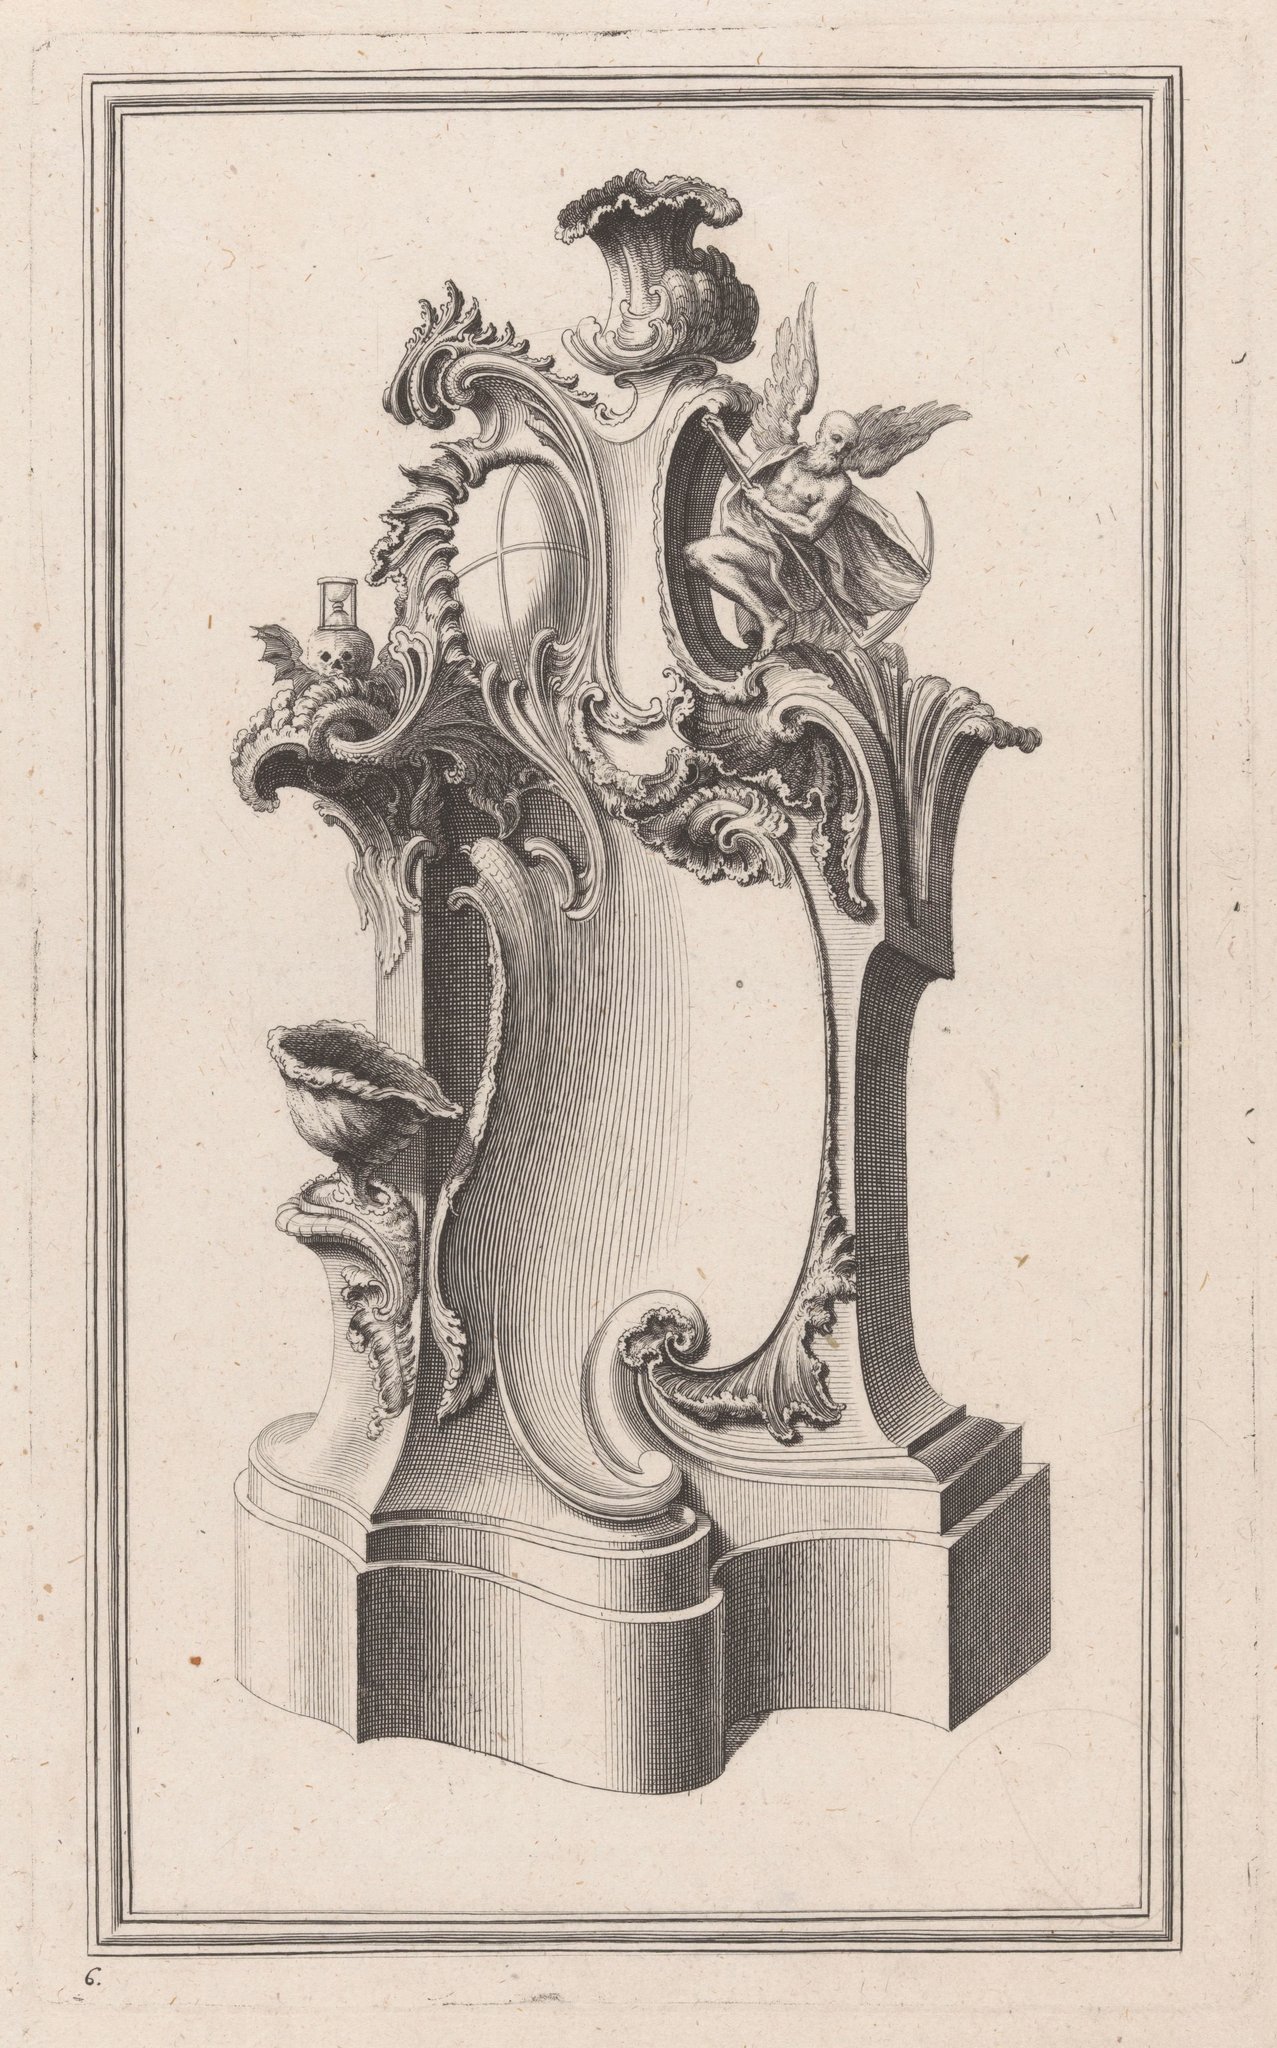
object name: print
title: Ontwerpen voor tabernakels, altaren en epitafen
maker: balthasar sigmund setletzky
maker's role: print maker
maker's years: 1695-1771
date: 1727-1754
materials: paper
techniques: engraving, etching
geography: augsburg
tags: rocaille ornament, skull as symbol of 'vanitas', epitaph, altar, father time, man with wings and scythe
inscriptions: collector's mark: Lugt 2228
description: Ontwerp voor een altaar of epitaaf met rocaille ornamenten en links een vaas. Aan de bovenzijde Vader Tijd met zeis en een gevleugeld doodshoofd met zandloper.